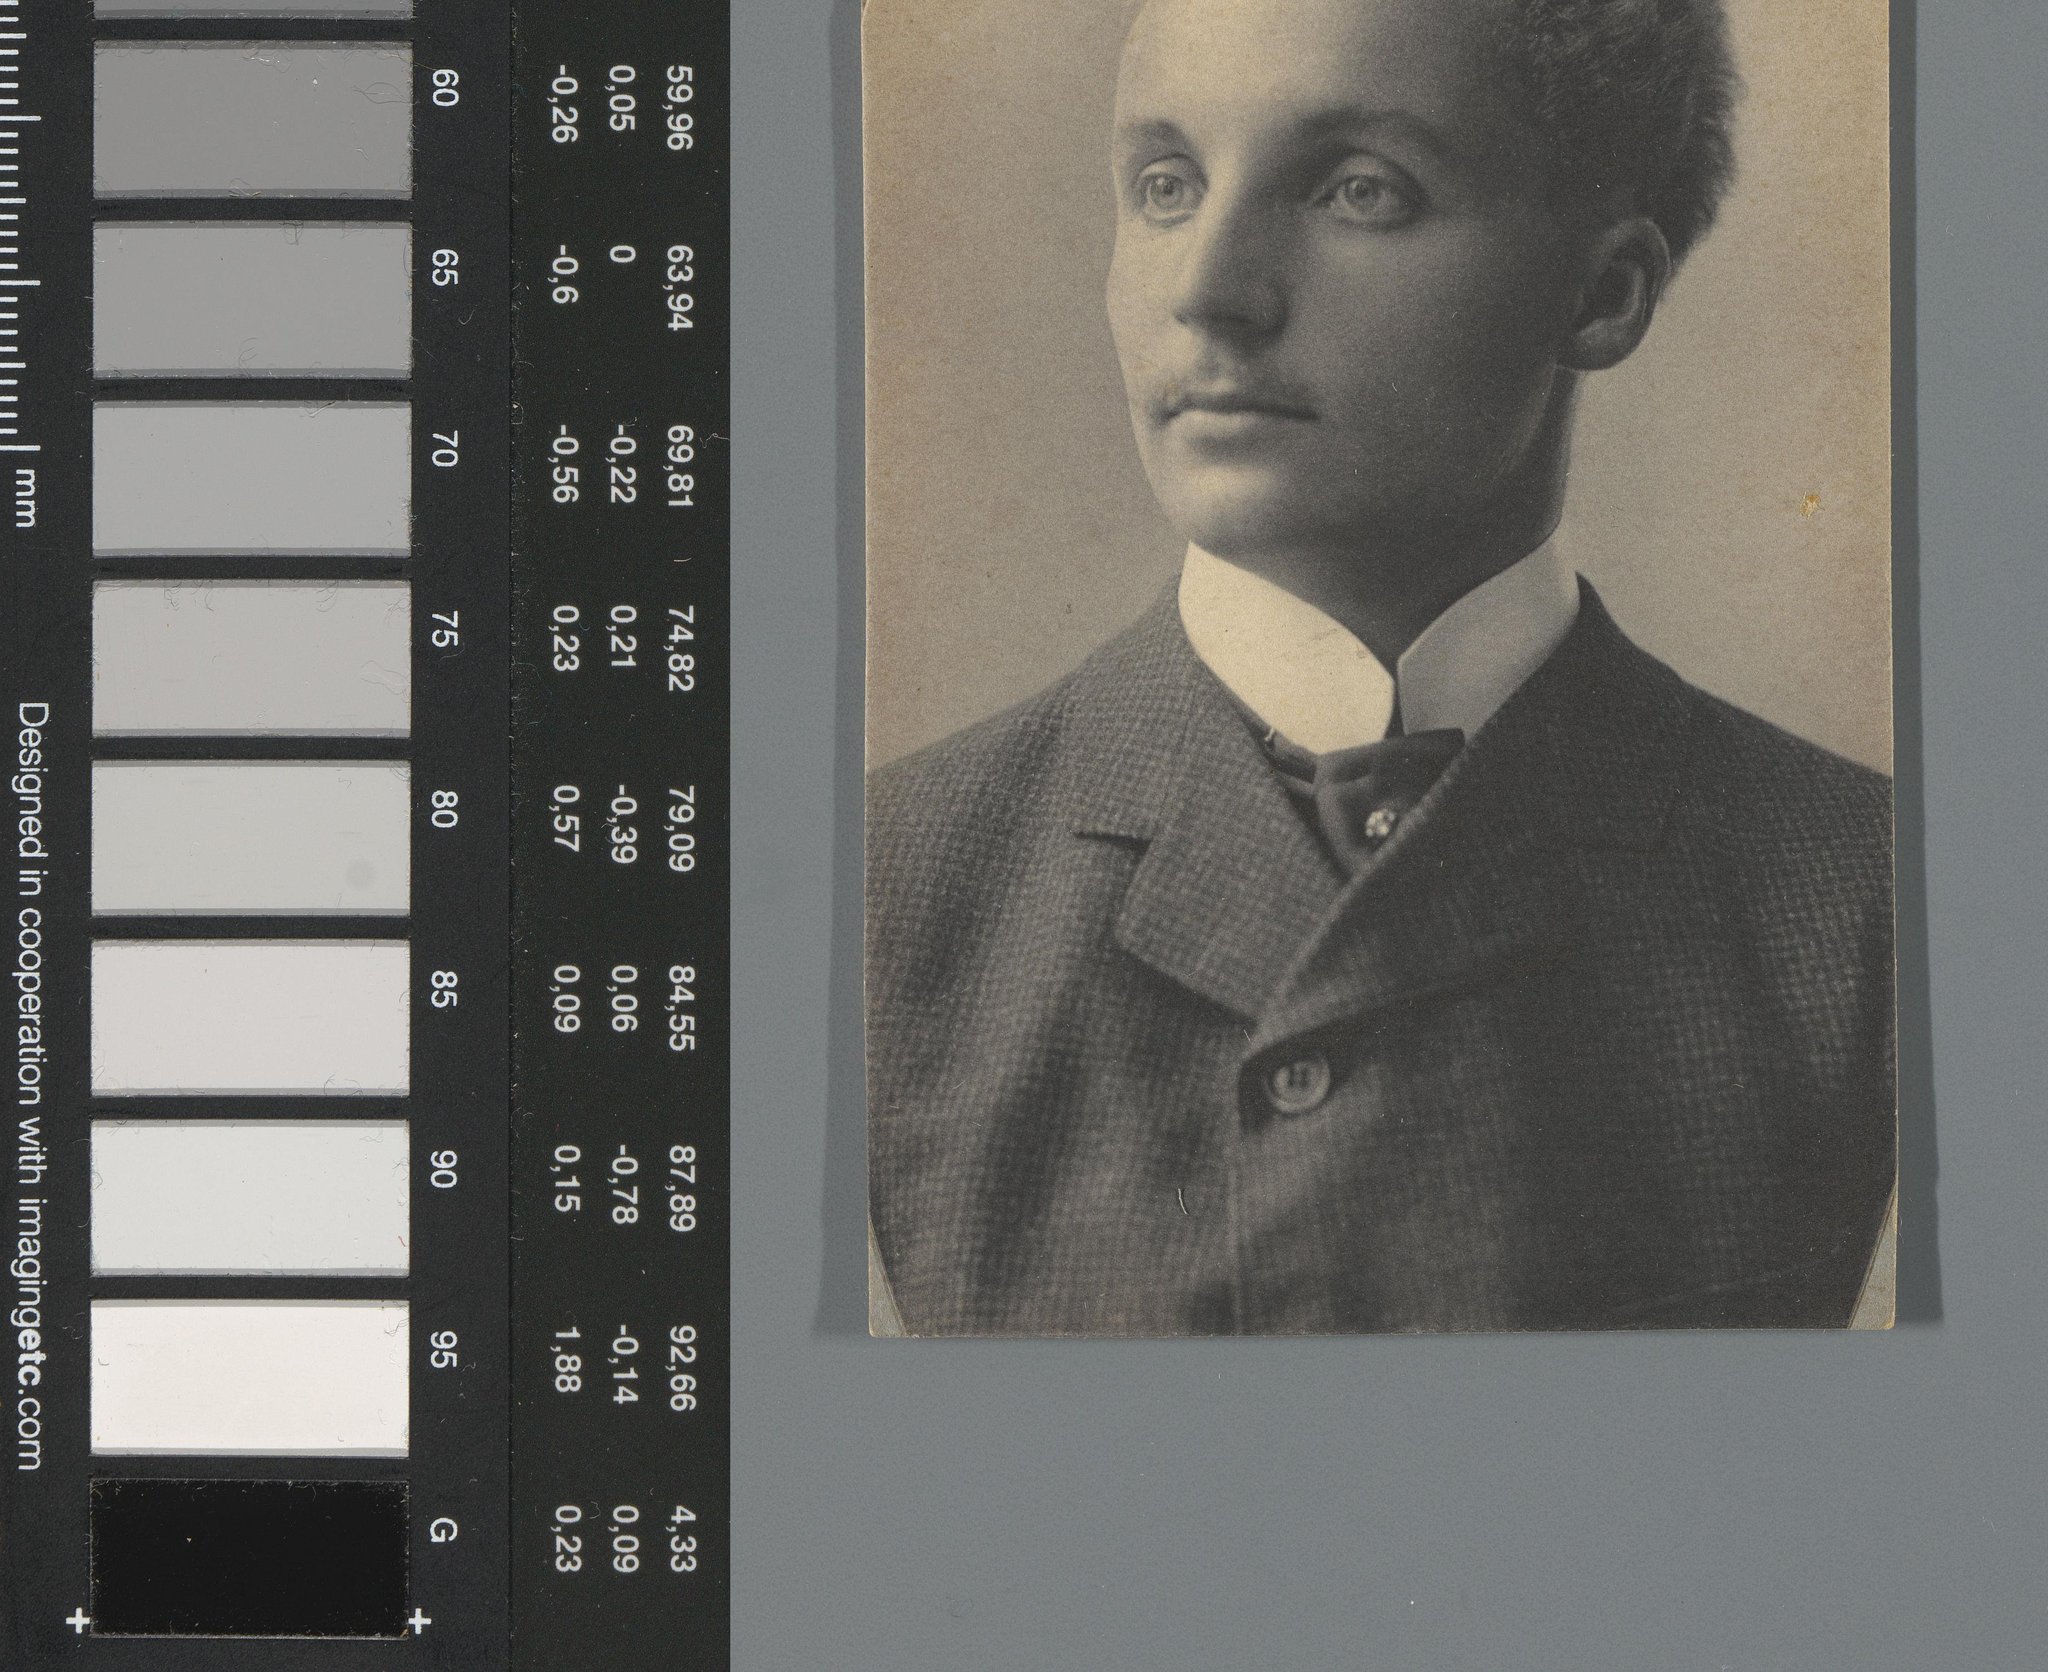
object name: photograph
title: Portret van Willem de Clercq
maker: Anonymous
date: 1868-1880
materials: cardboard, photographic support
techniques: photography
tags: historical persons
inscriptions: annotation: ‘W. de Clercq’